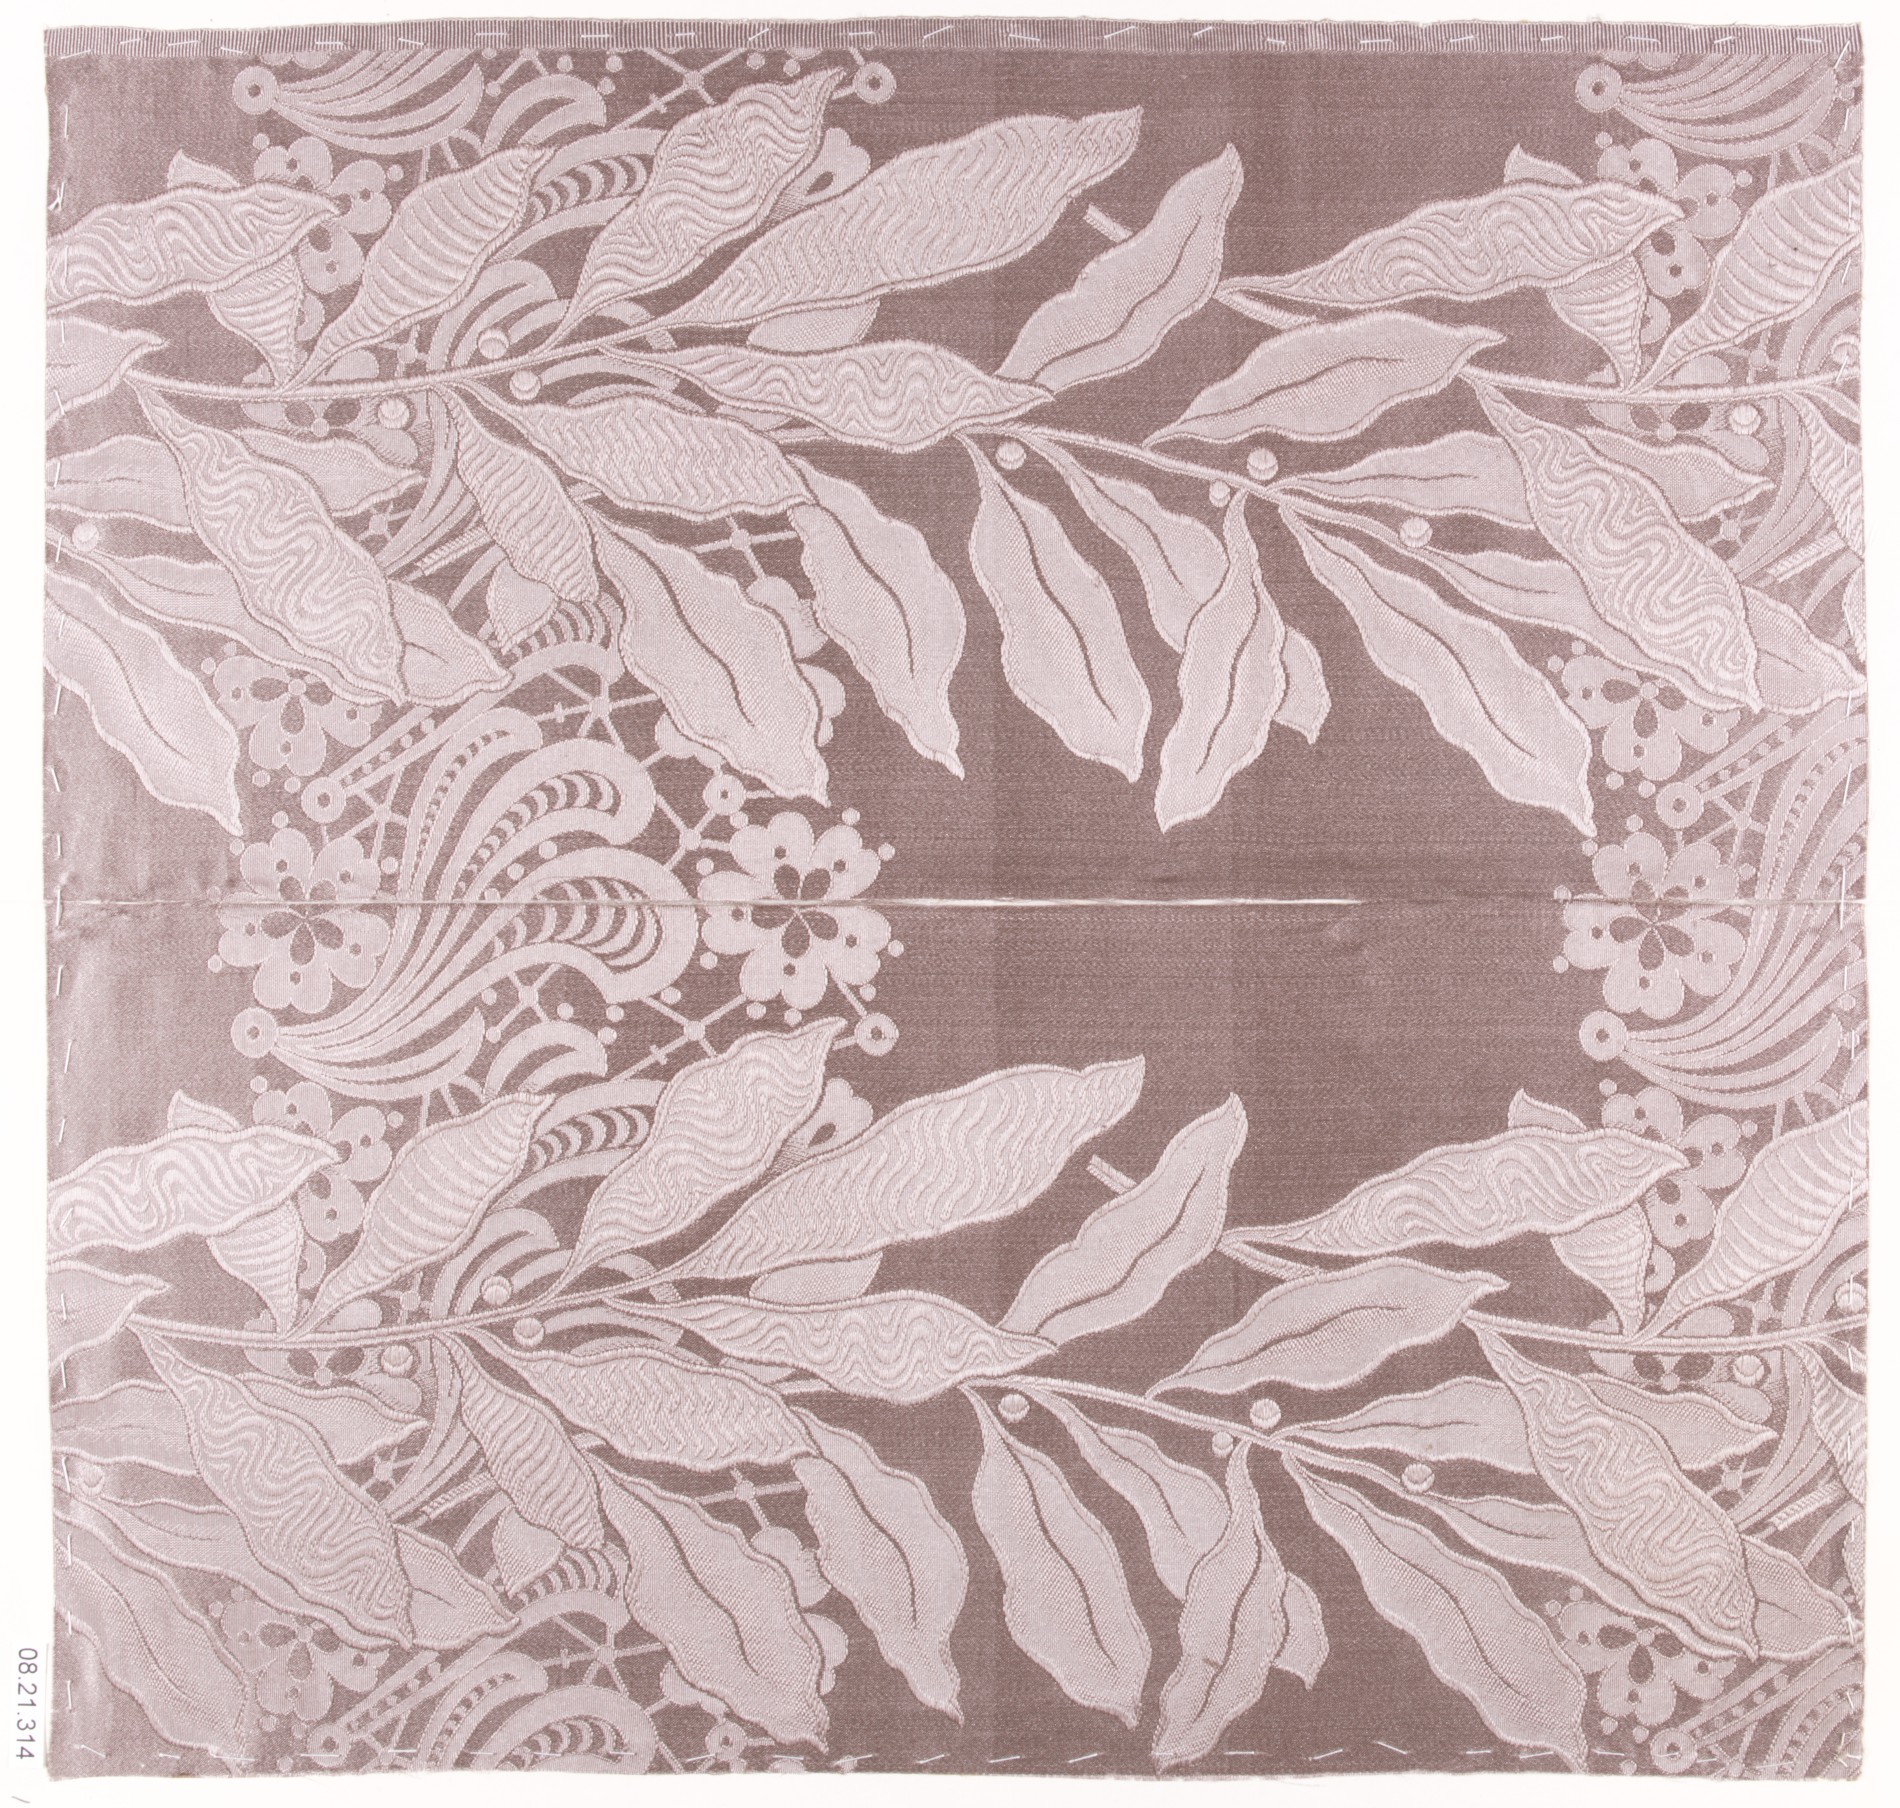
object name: textile sample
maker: Anonymous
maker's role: designer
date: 1900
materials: silk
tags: leaves